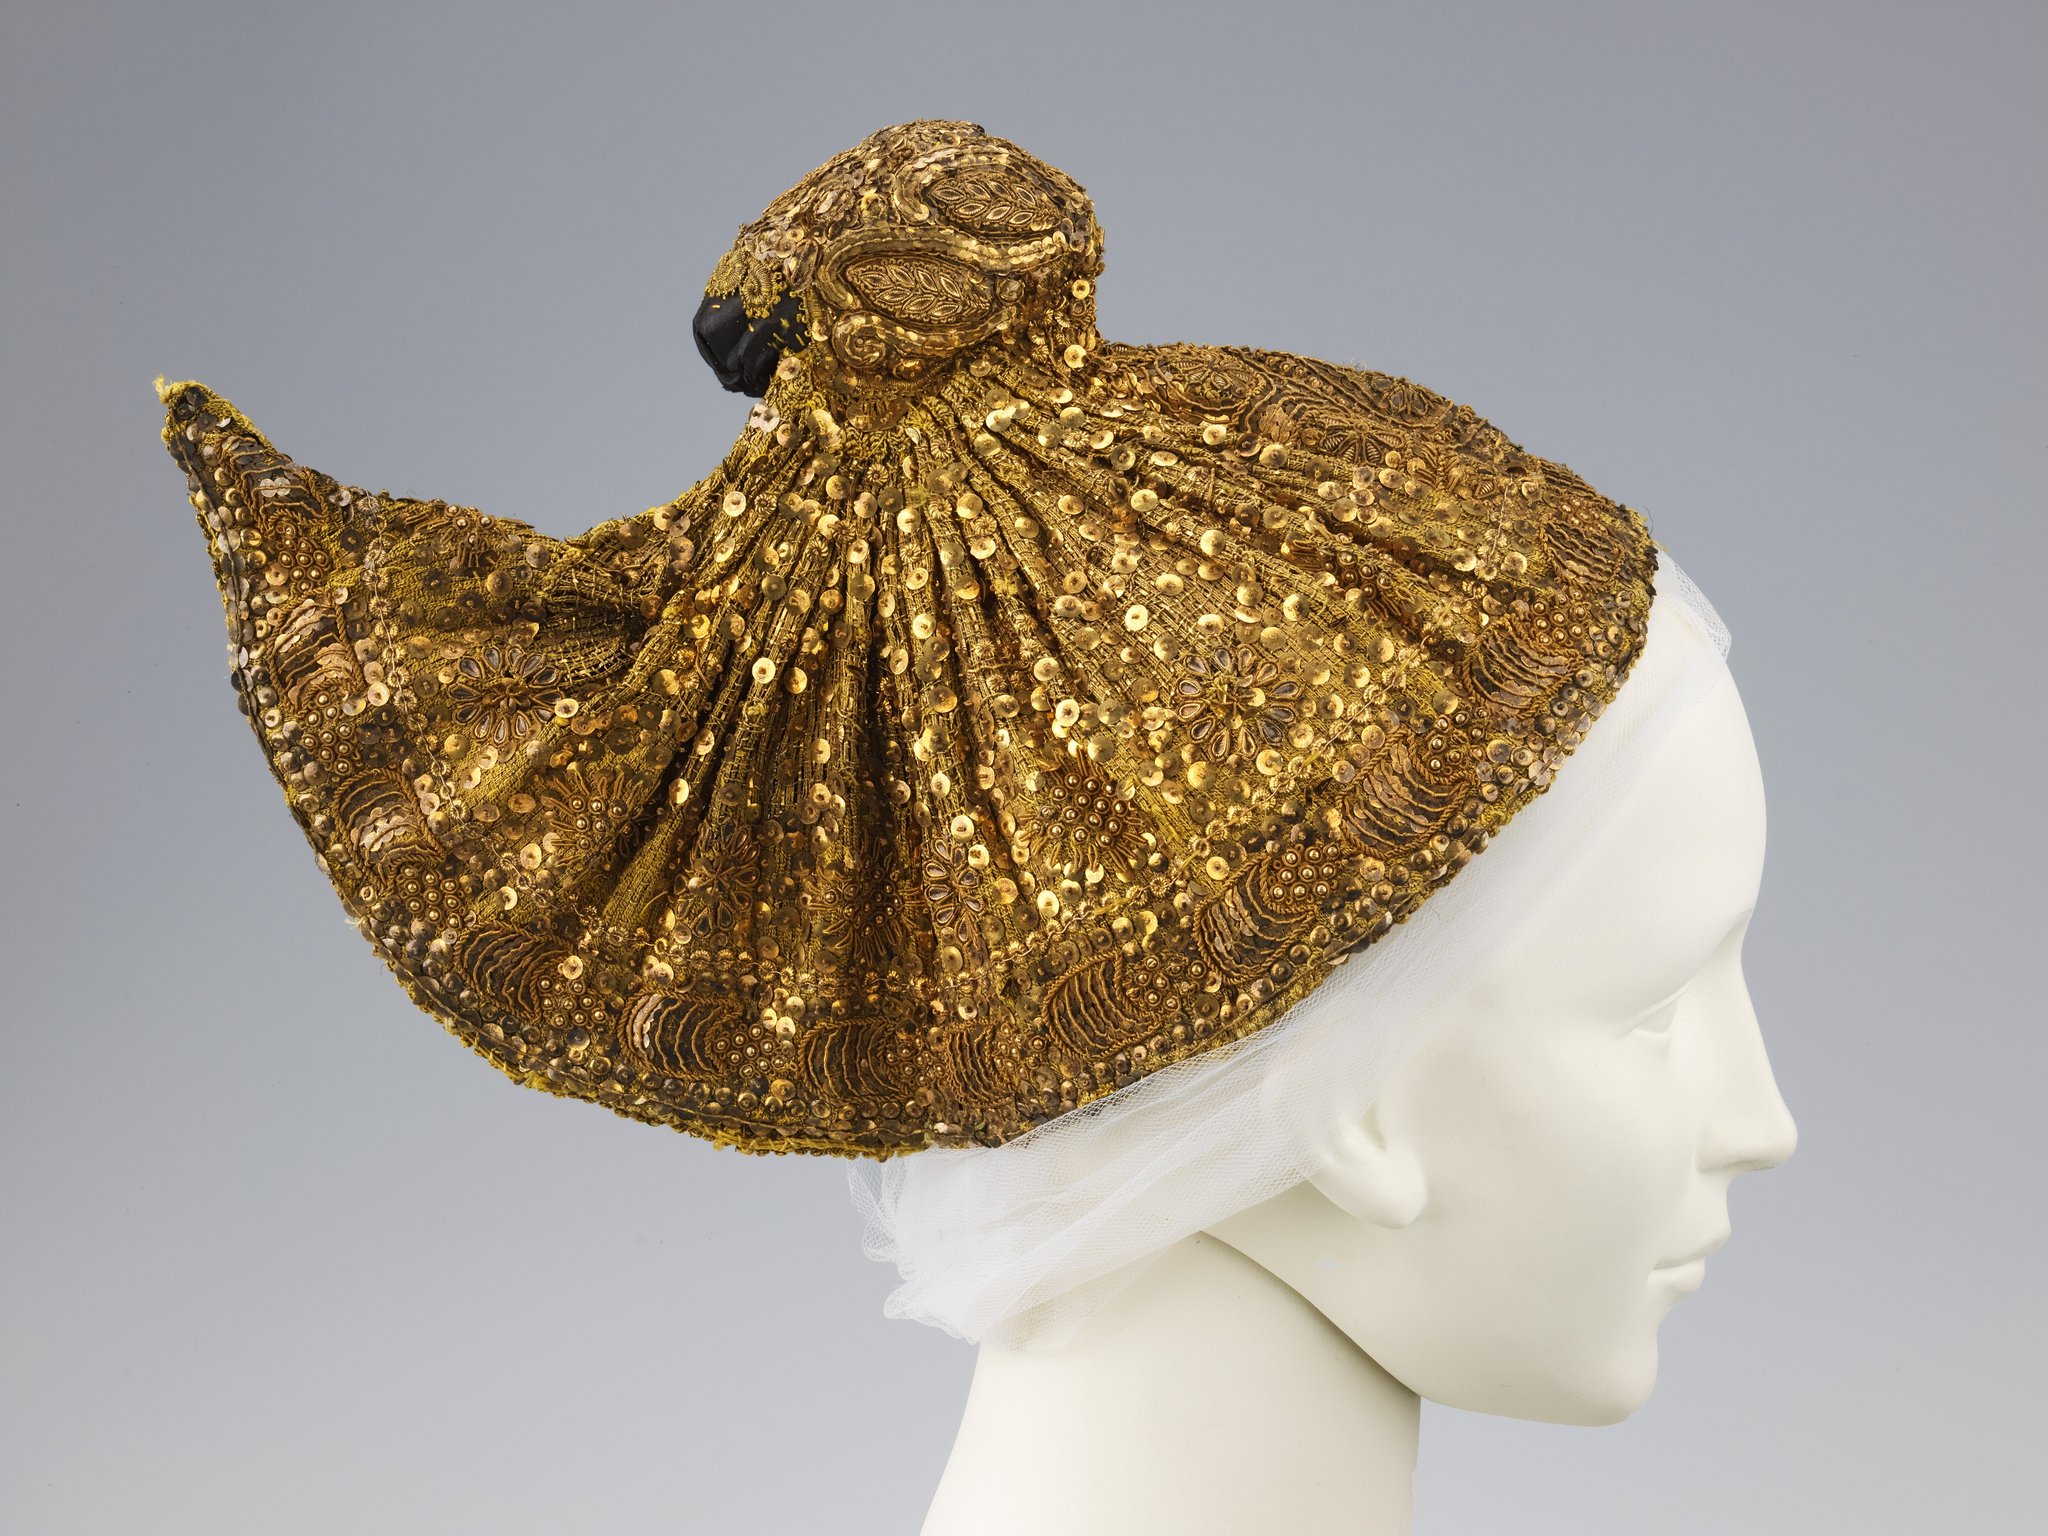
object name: cap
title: Golden Hood of Linz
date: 1835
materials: linen, metal, silk